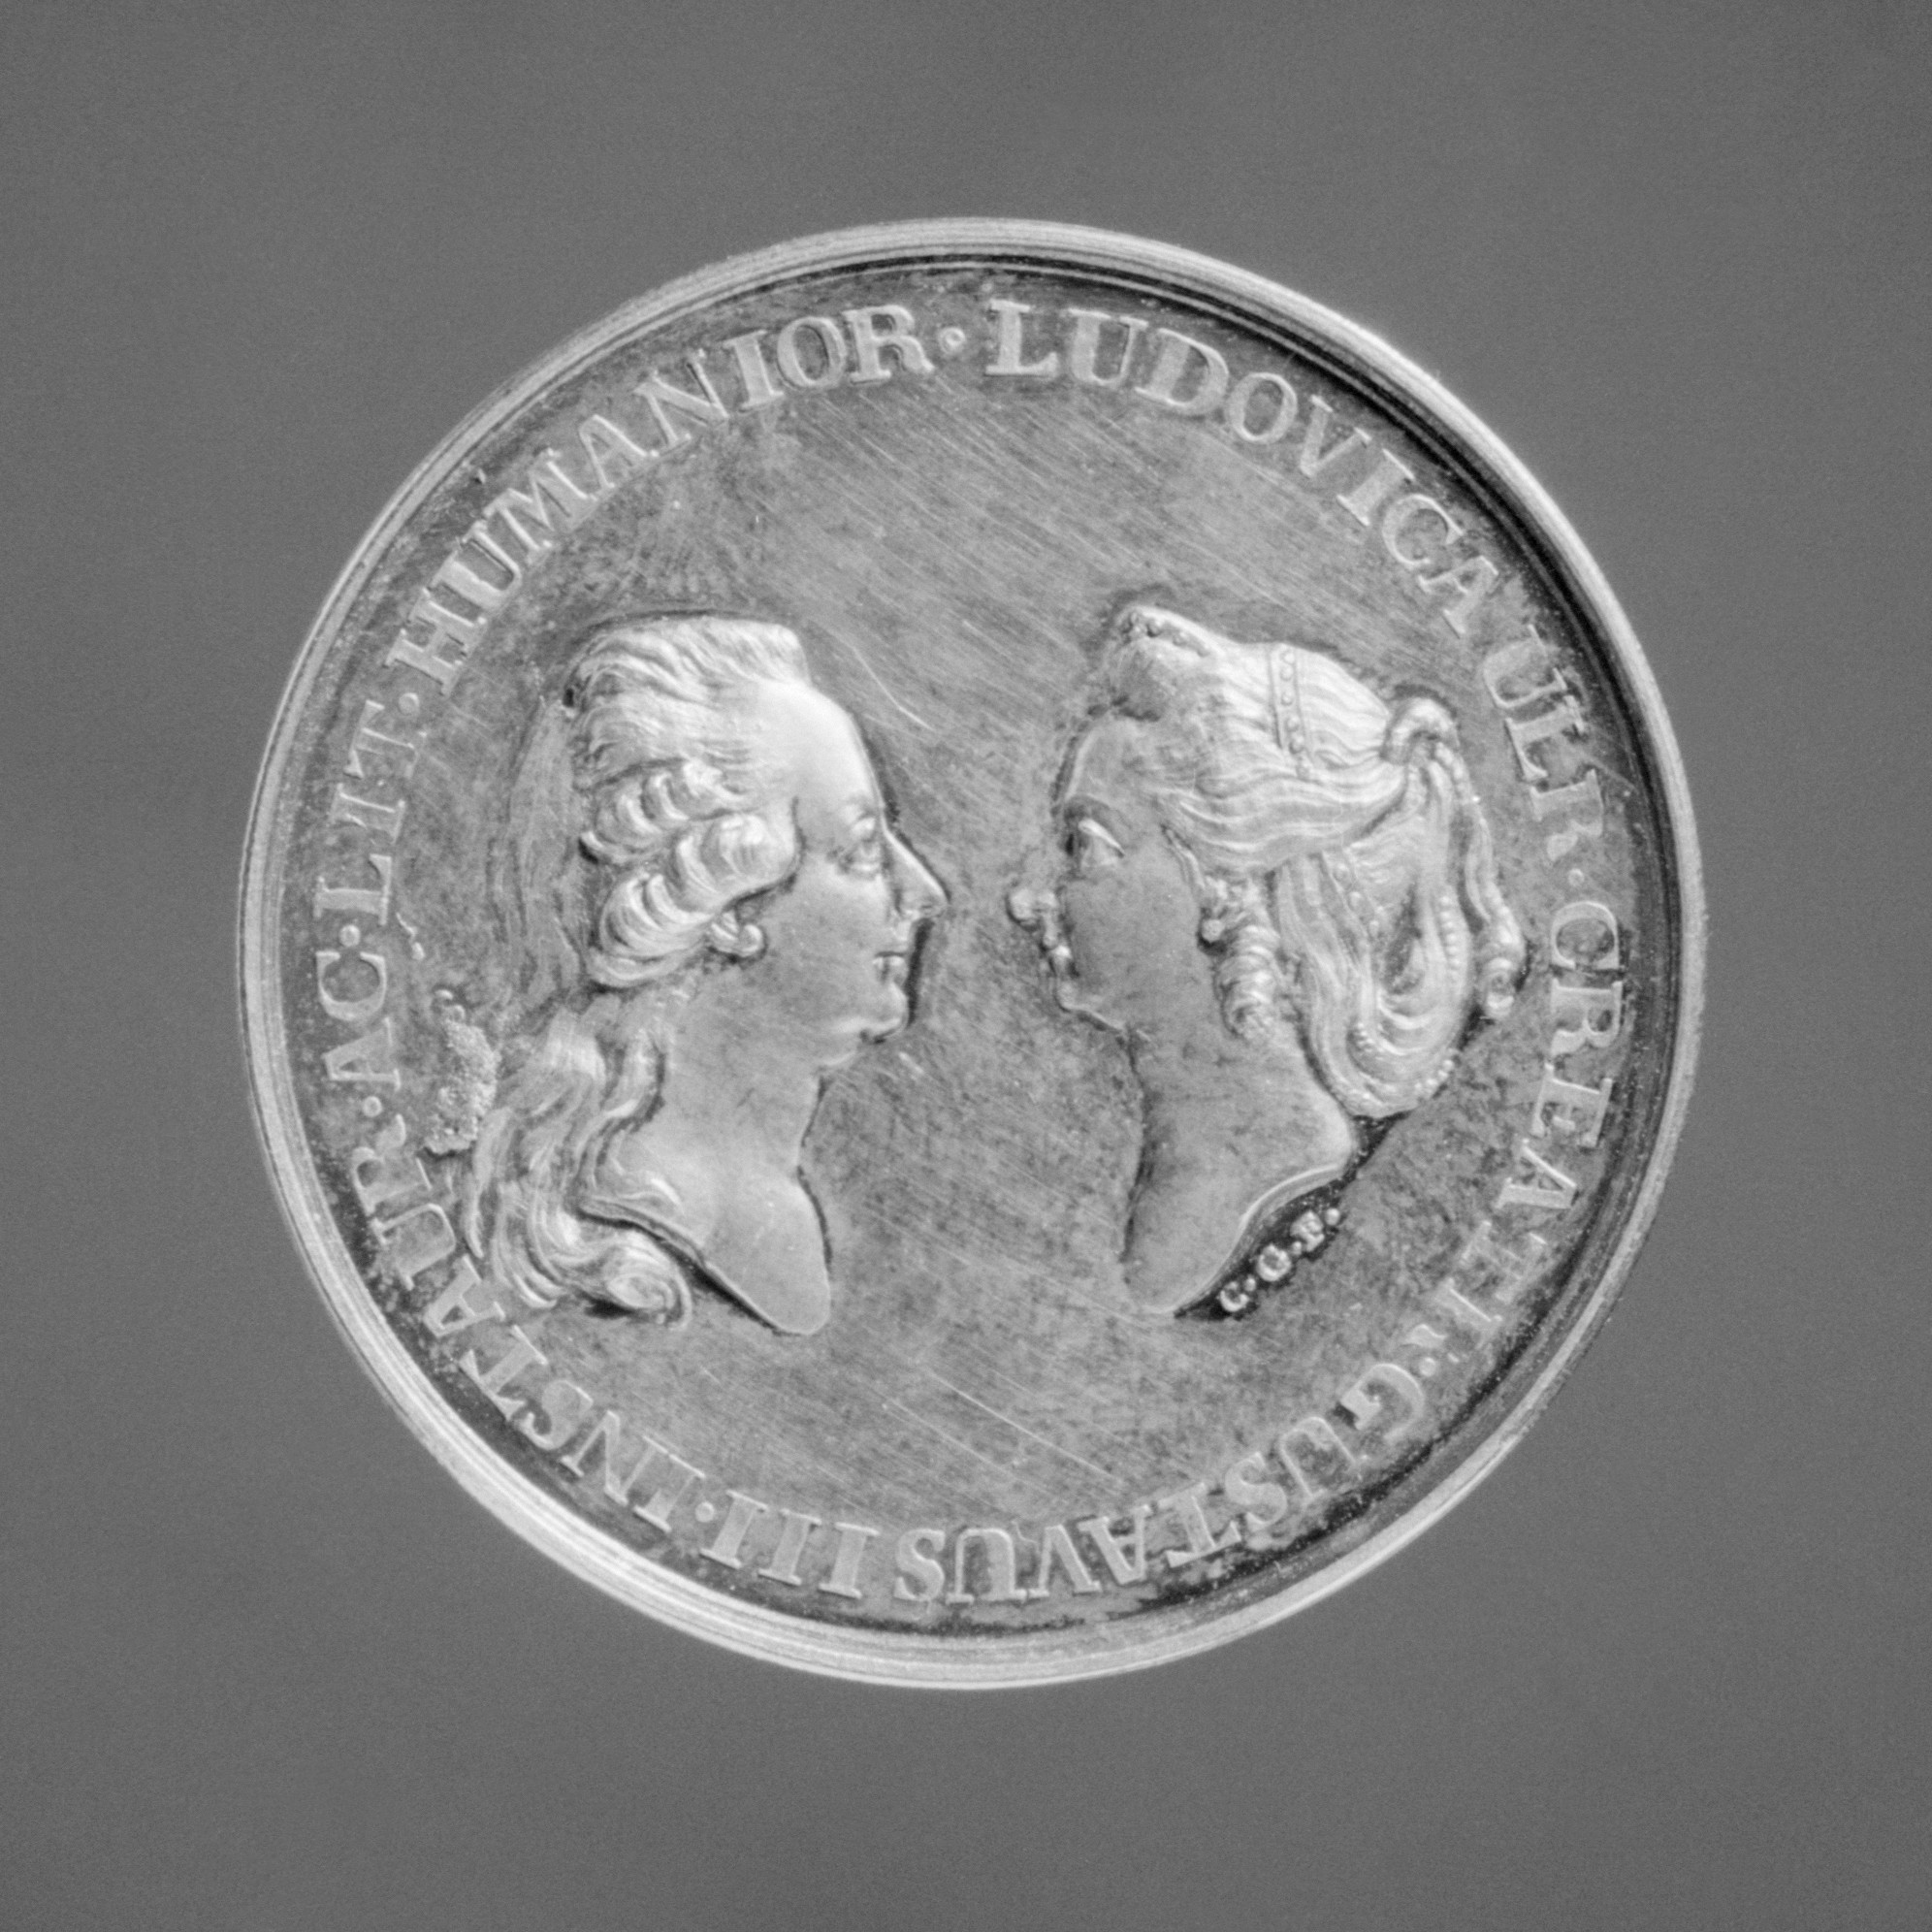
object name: medal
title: Gustavus III, King of Sweden (b. 1746, r. 1771–92) and Louise Ulrika, his mother (1720–1782), as founders of the Swedish Academy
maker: carl gustaf fehrman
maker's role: artist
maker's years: 1746-1798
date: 1786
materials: silver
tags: kings,profiles,women